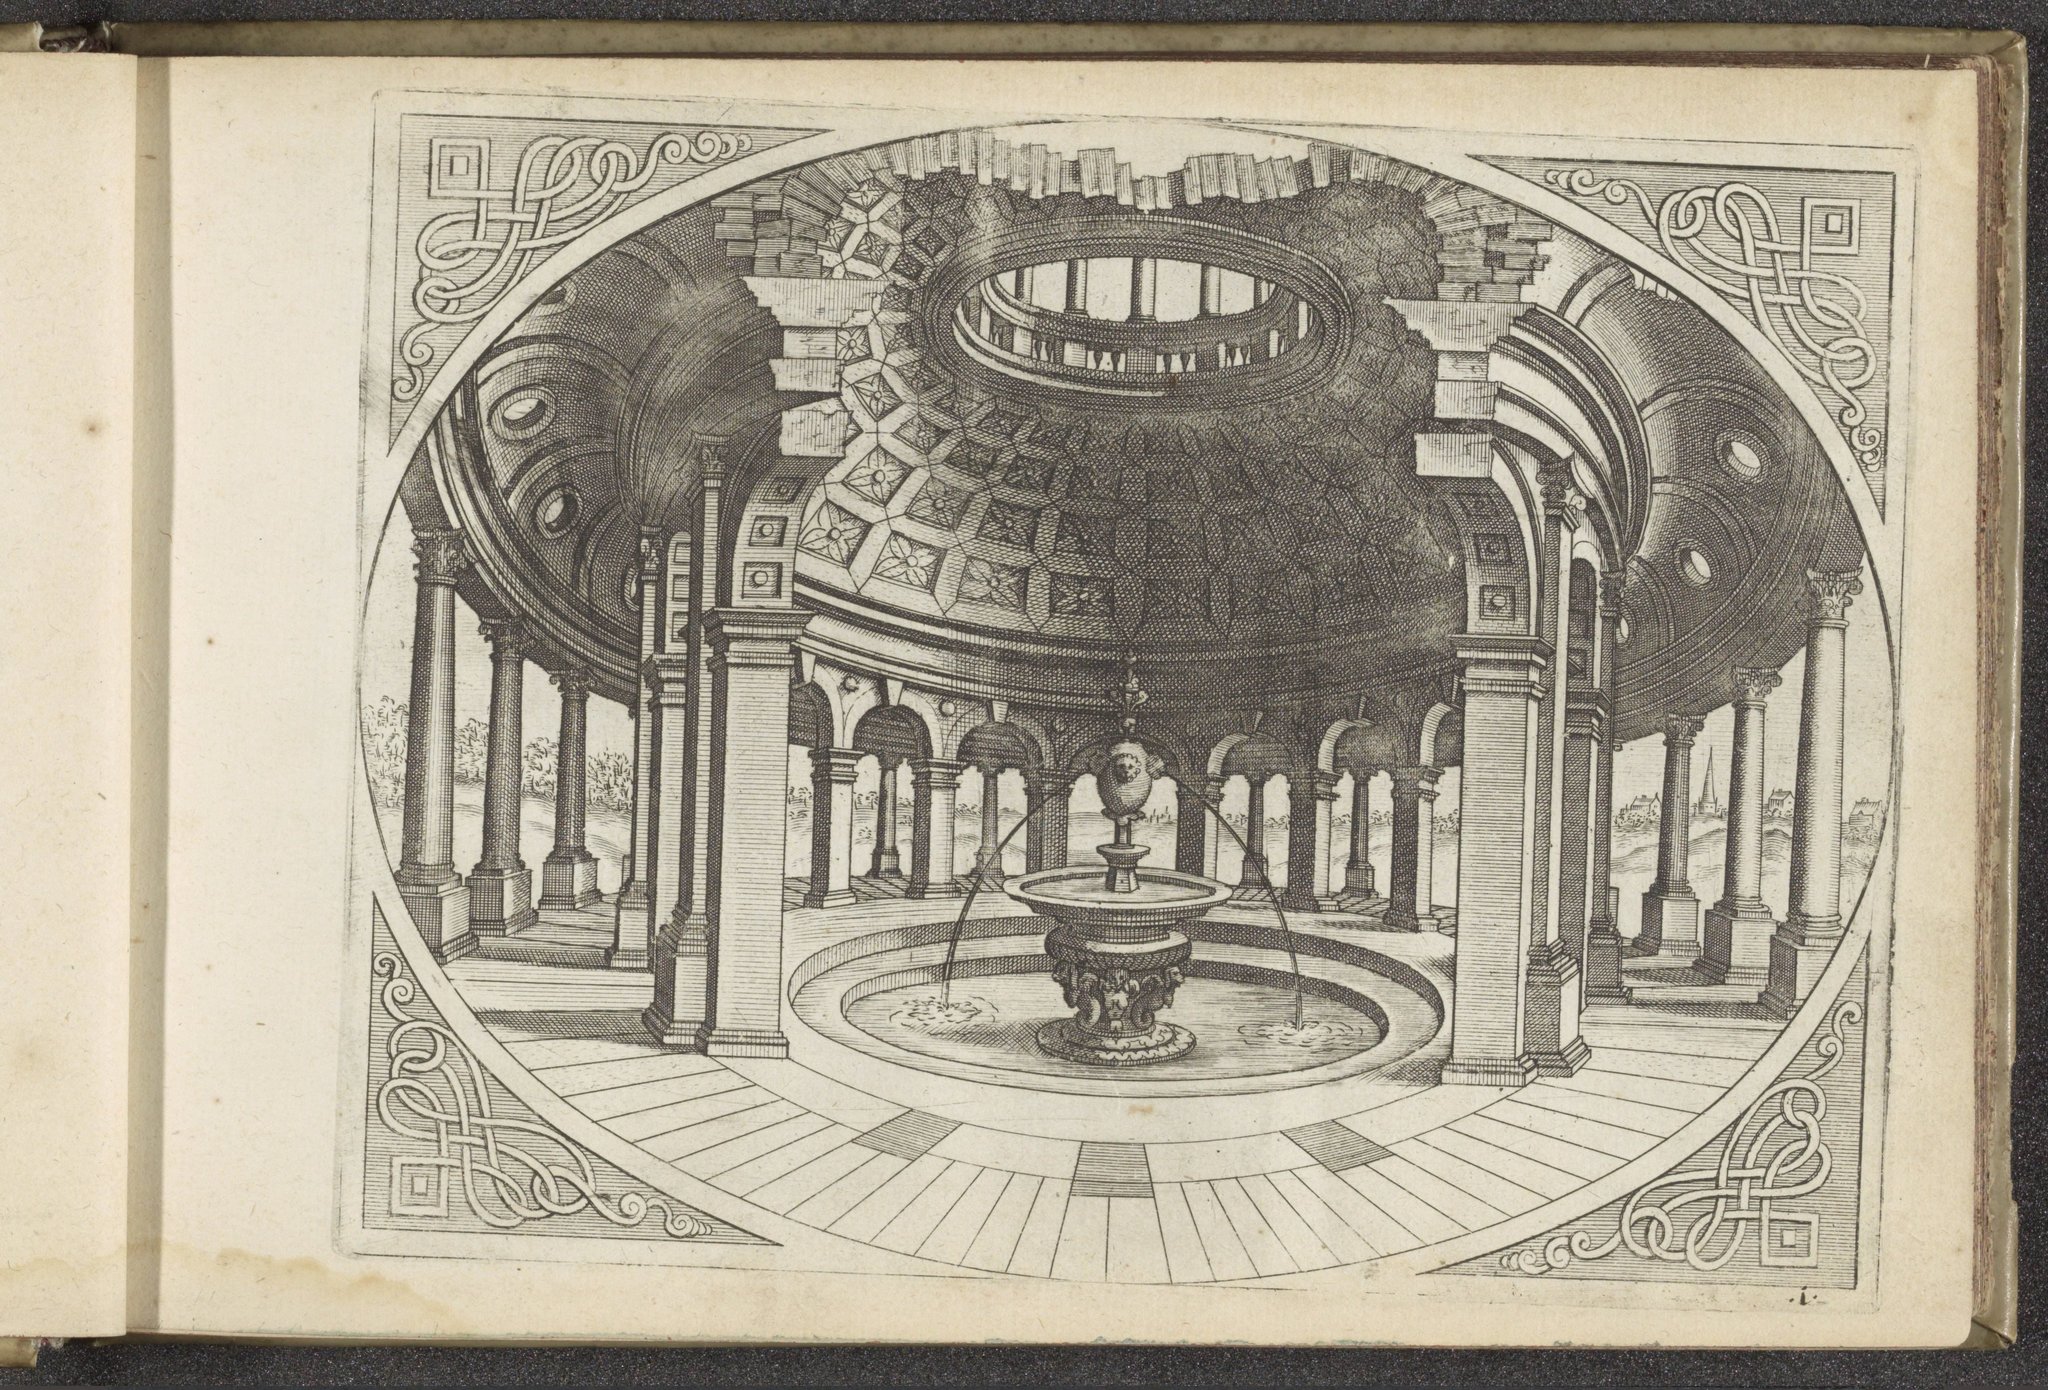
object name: album leaf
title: Ovale architectectonische perspectivische gezichten voor intarsia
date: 1560-1562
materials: paper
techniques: etching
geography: antwerp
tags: architectural representations in general, ornamental fountain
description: Open ronde tempel met centraal bassin en fontein. In de hoeken ornament. Deze prent maakt deel uit van een album.